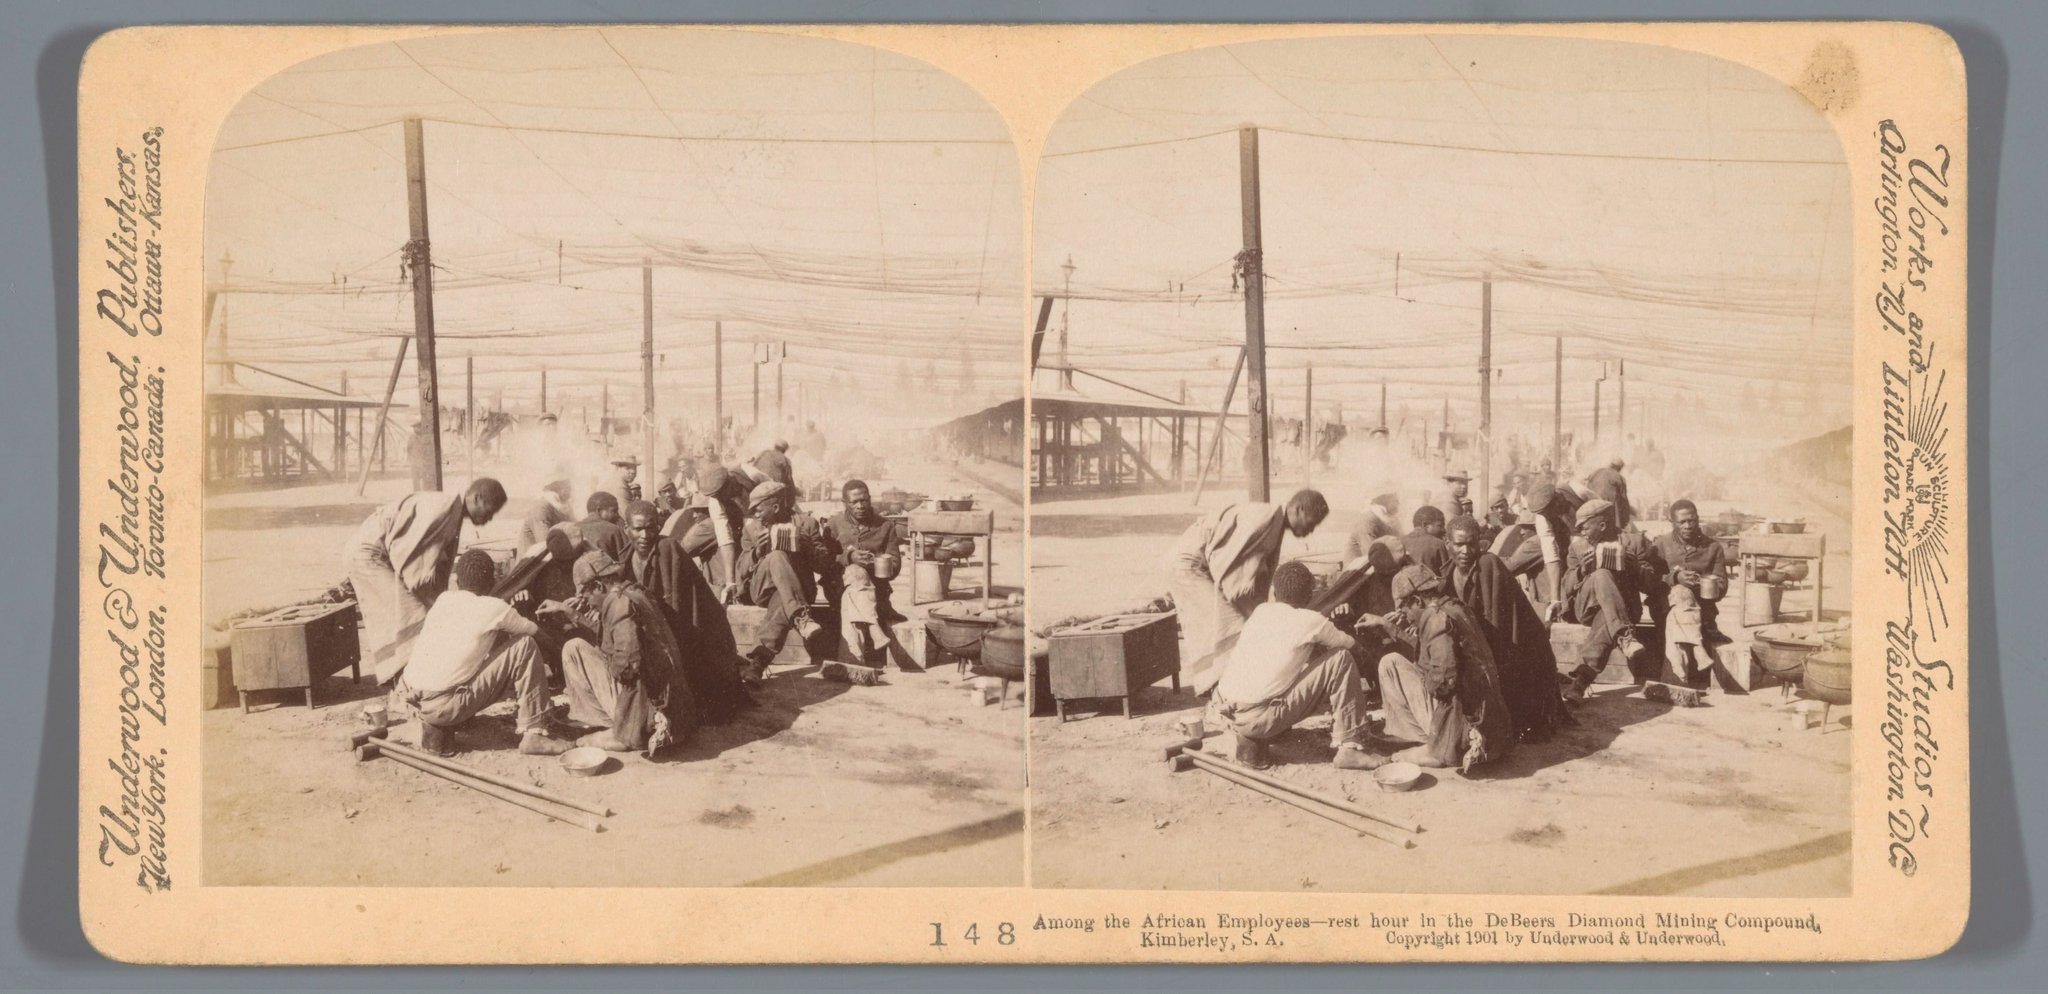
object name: stereograph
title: Rustende Afrikaanse mijnwerkers bij een diamantmijn van De Beers in Kimberley, Zuid-Afrika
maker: Anonymous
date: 1901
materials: cardboard, paper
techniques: albumen print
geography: new york city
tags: miner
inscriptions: number: ‘148’, inscription, copyright notice: ‘Copyright 1901 by Underwood & Underwood.’, inscription: ‘Works and Studios ~/ Arlington, N.J. Littleton, N.H. Washington, D.C.’